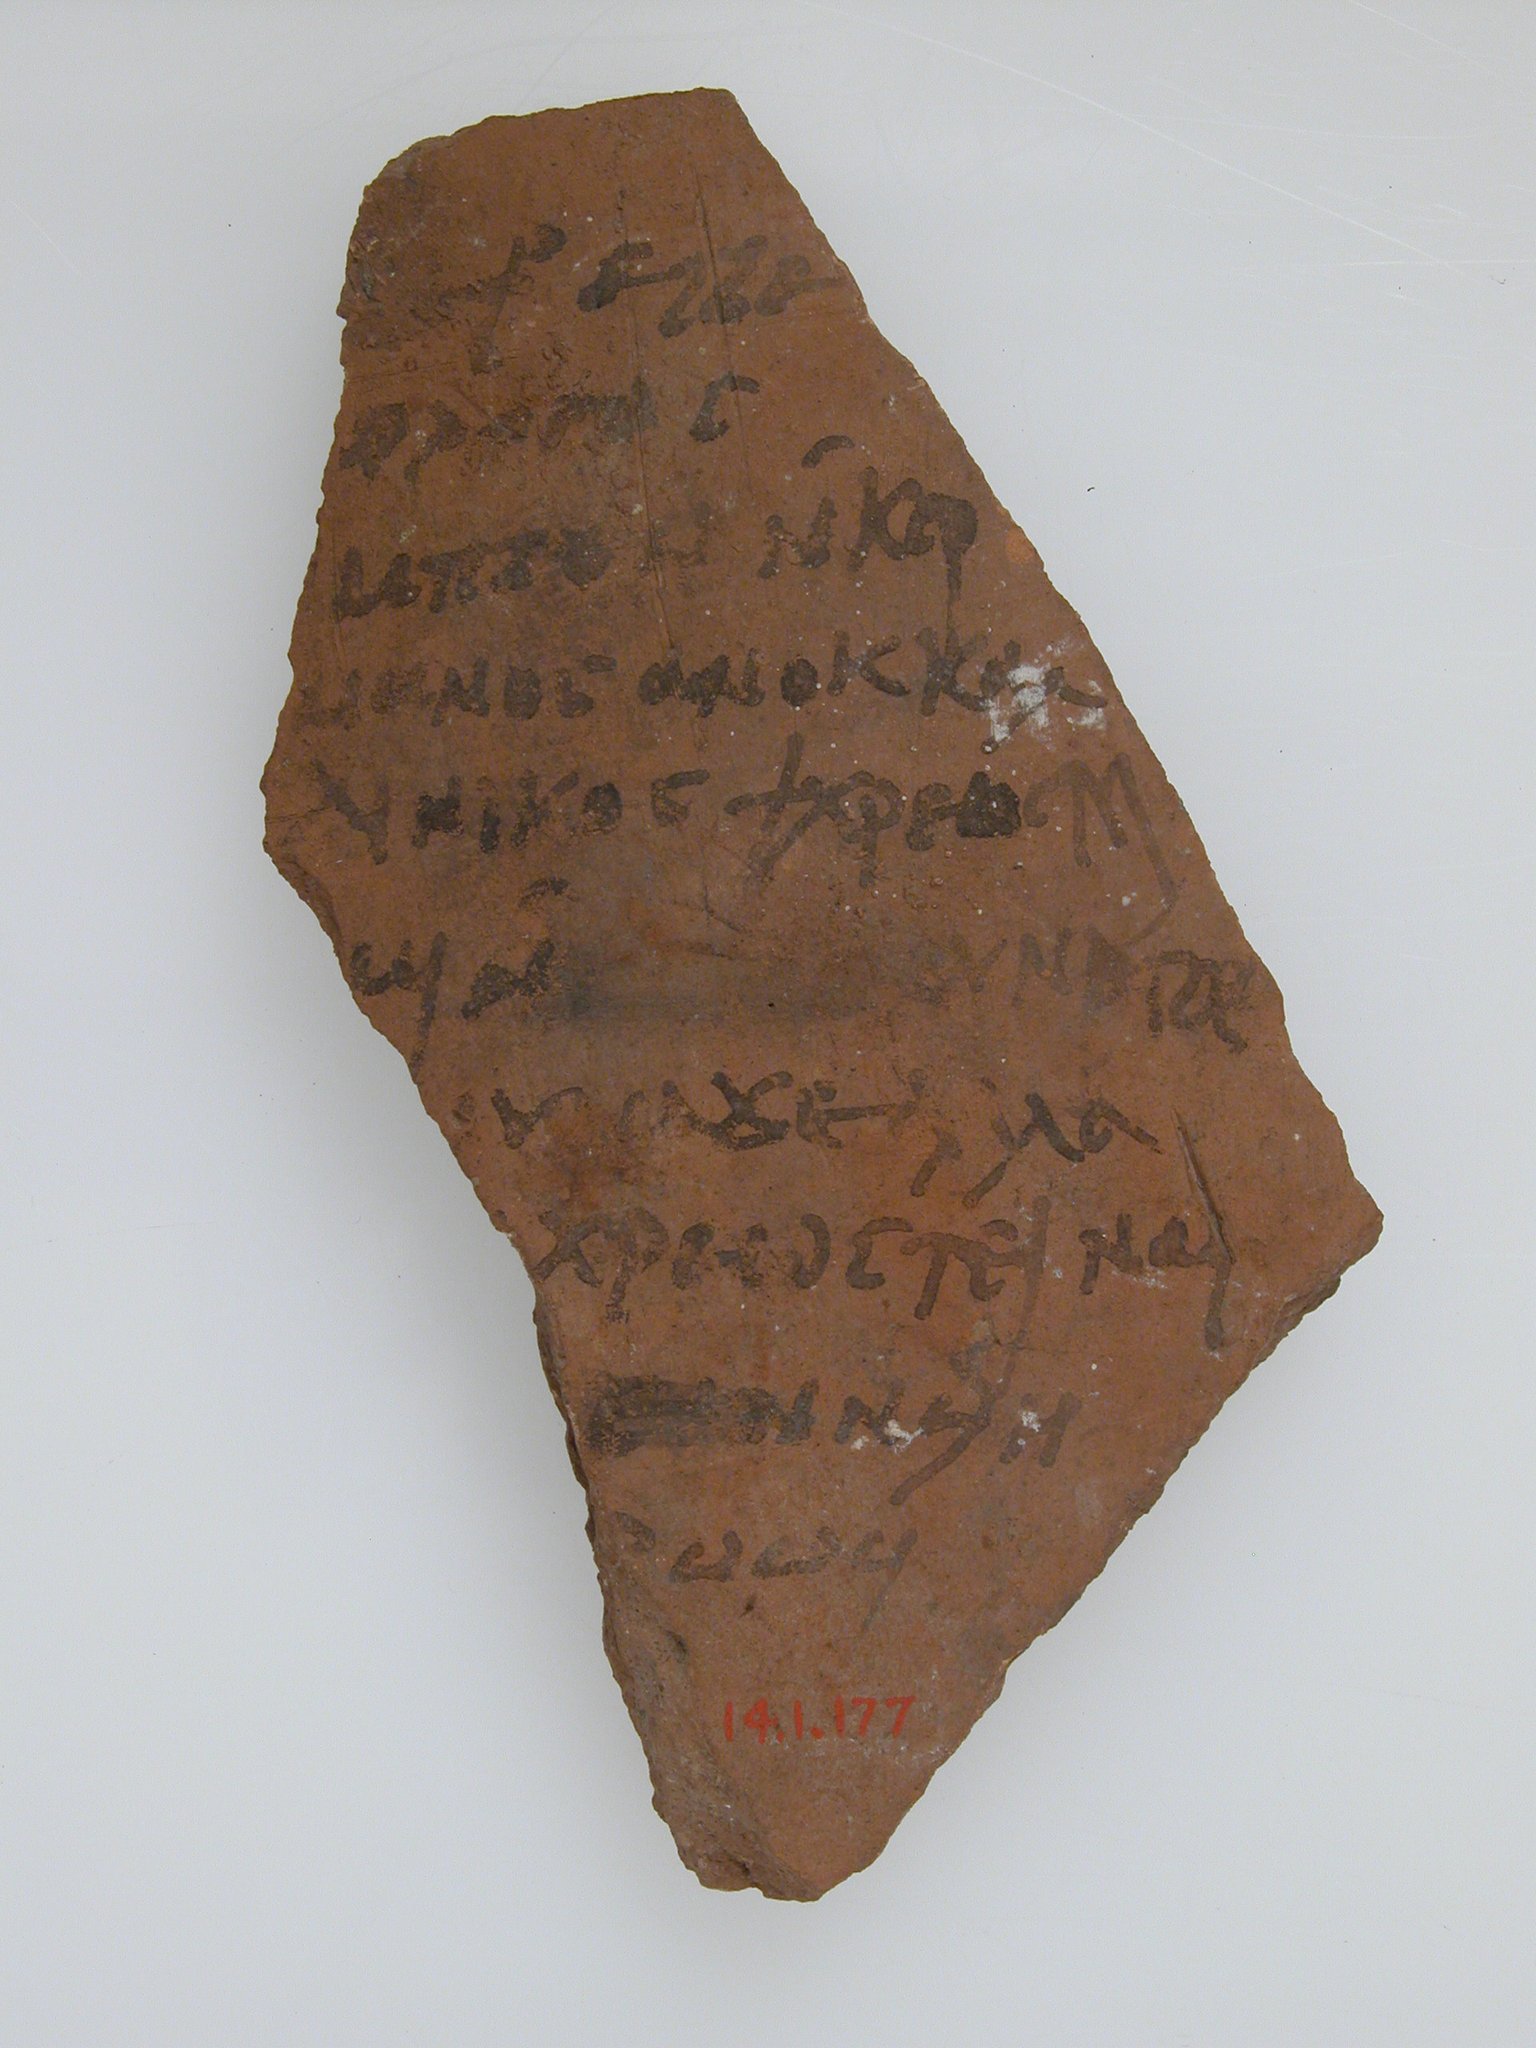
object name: ostrakon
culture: coptic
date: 580-640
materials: ink, pottery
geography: egypt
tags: coptic,documents